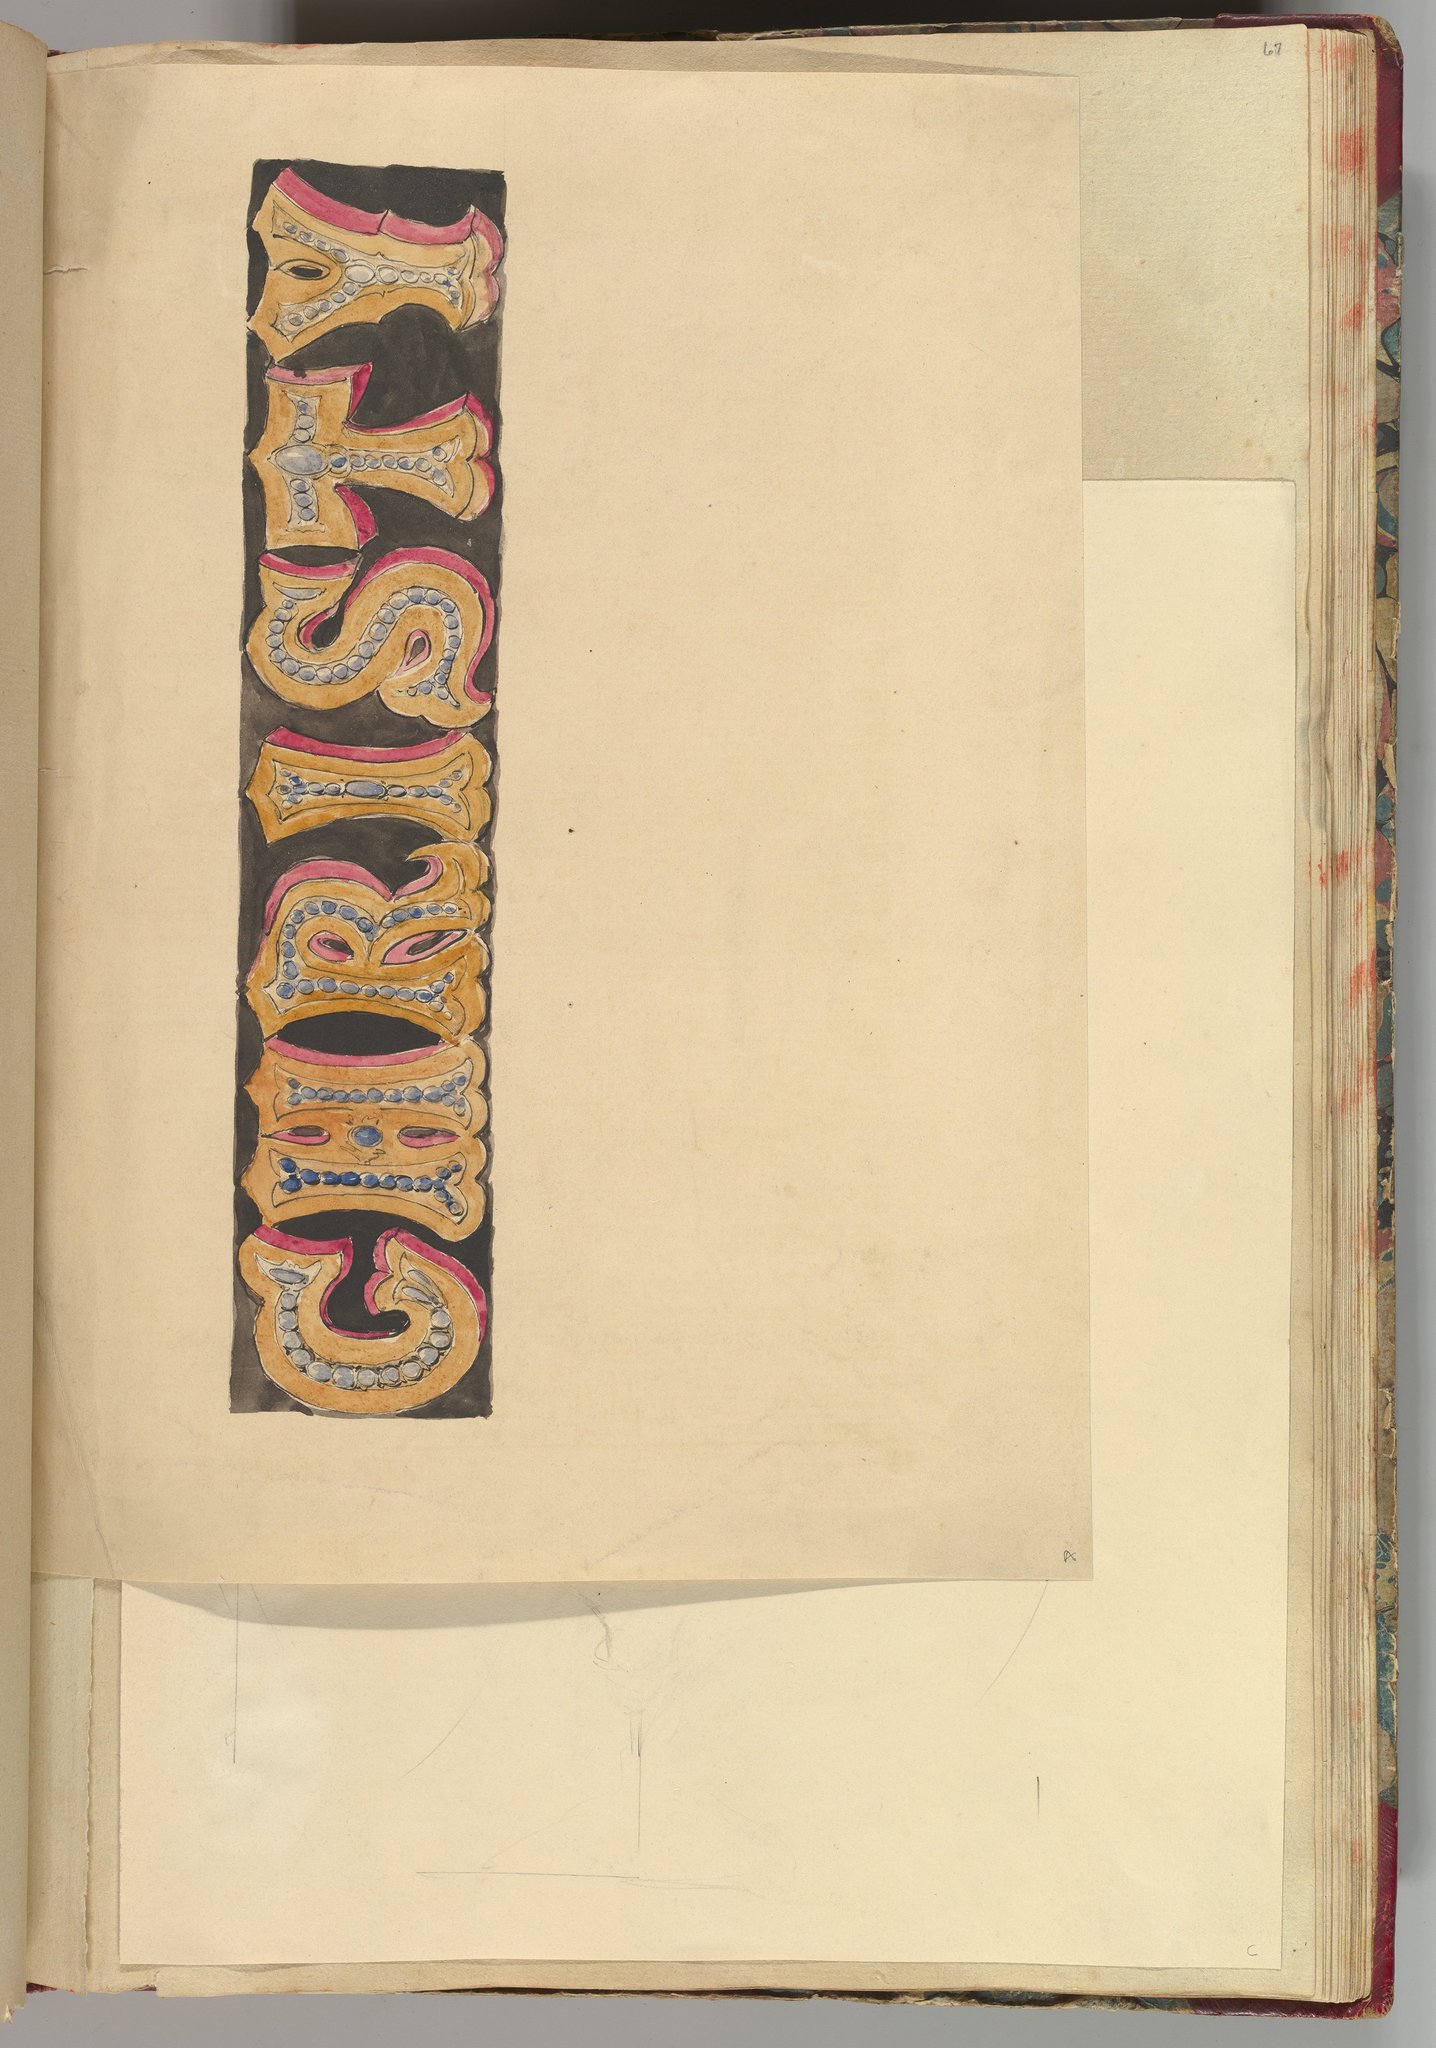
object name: drawing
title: Lettered title: Christy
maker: alfred henry forrester [alfred crowquill]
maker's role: artist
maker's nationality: british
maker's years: 1804-1872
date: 1845-1855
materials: gouache